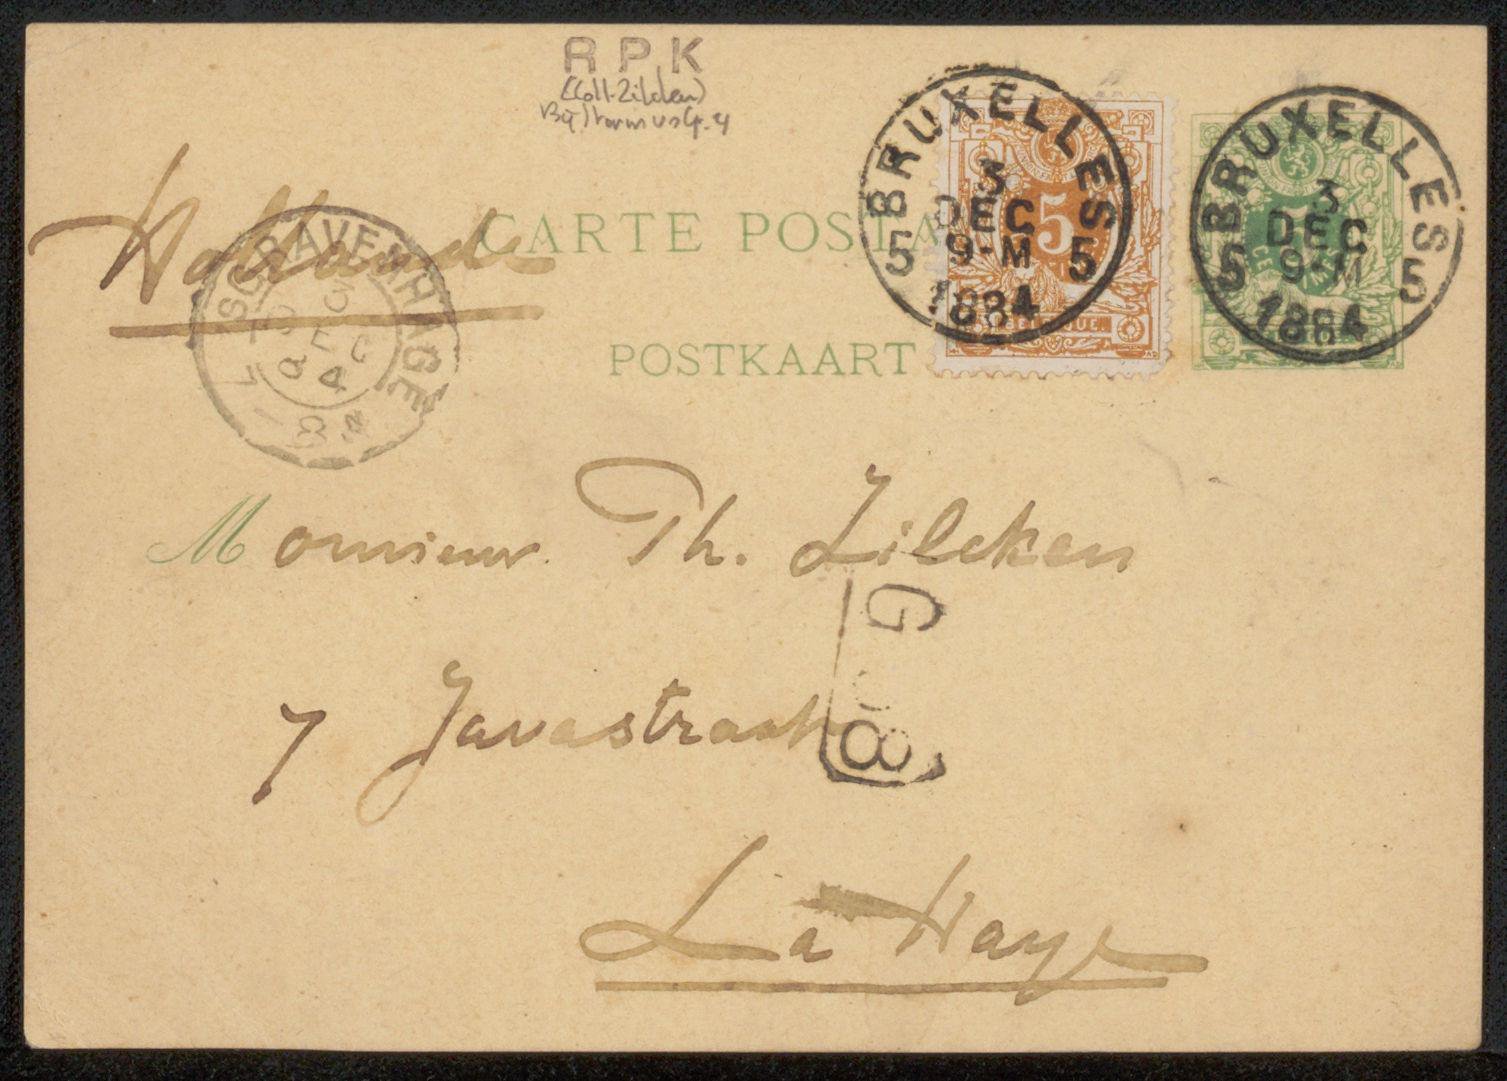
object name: postcard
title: Briefkaart aan Philip Zilcken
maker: carel nicolaas storm van s-gravesande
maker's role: draughtsman, print maker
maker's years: 1841-1924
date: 1884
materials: cardboard, ink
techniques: pen, writing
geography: brussels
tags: painter, philip zilcken, the graphic arts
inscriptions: collector's mark: ‘RPK’